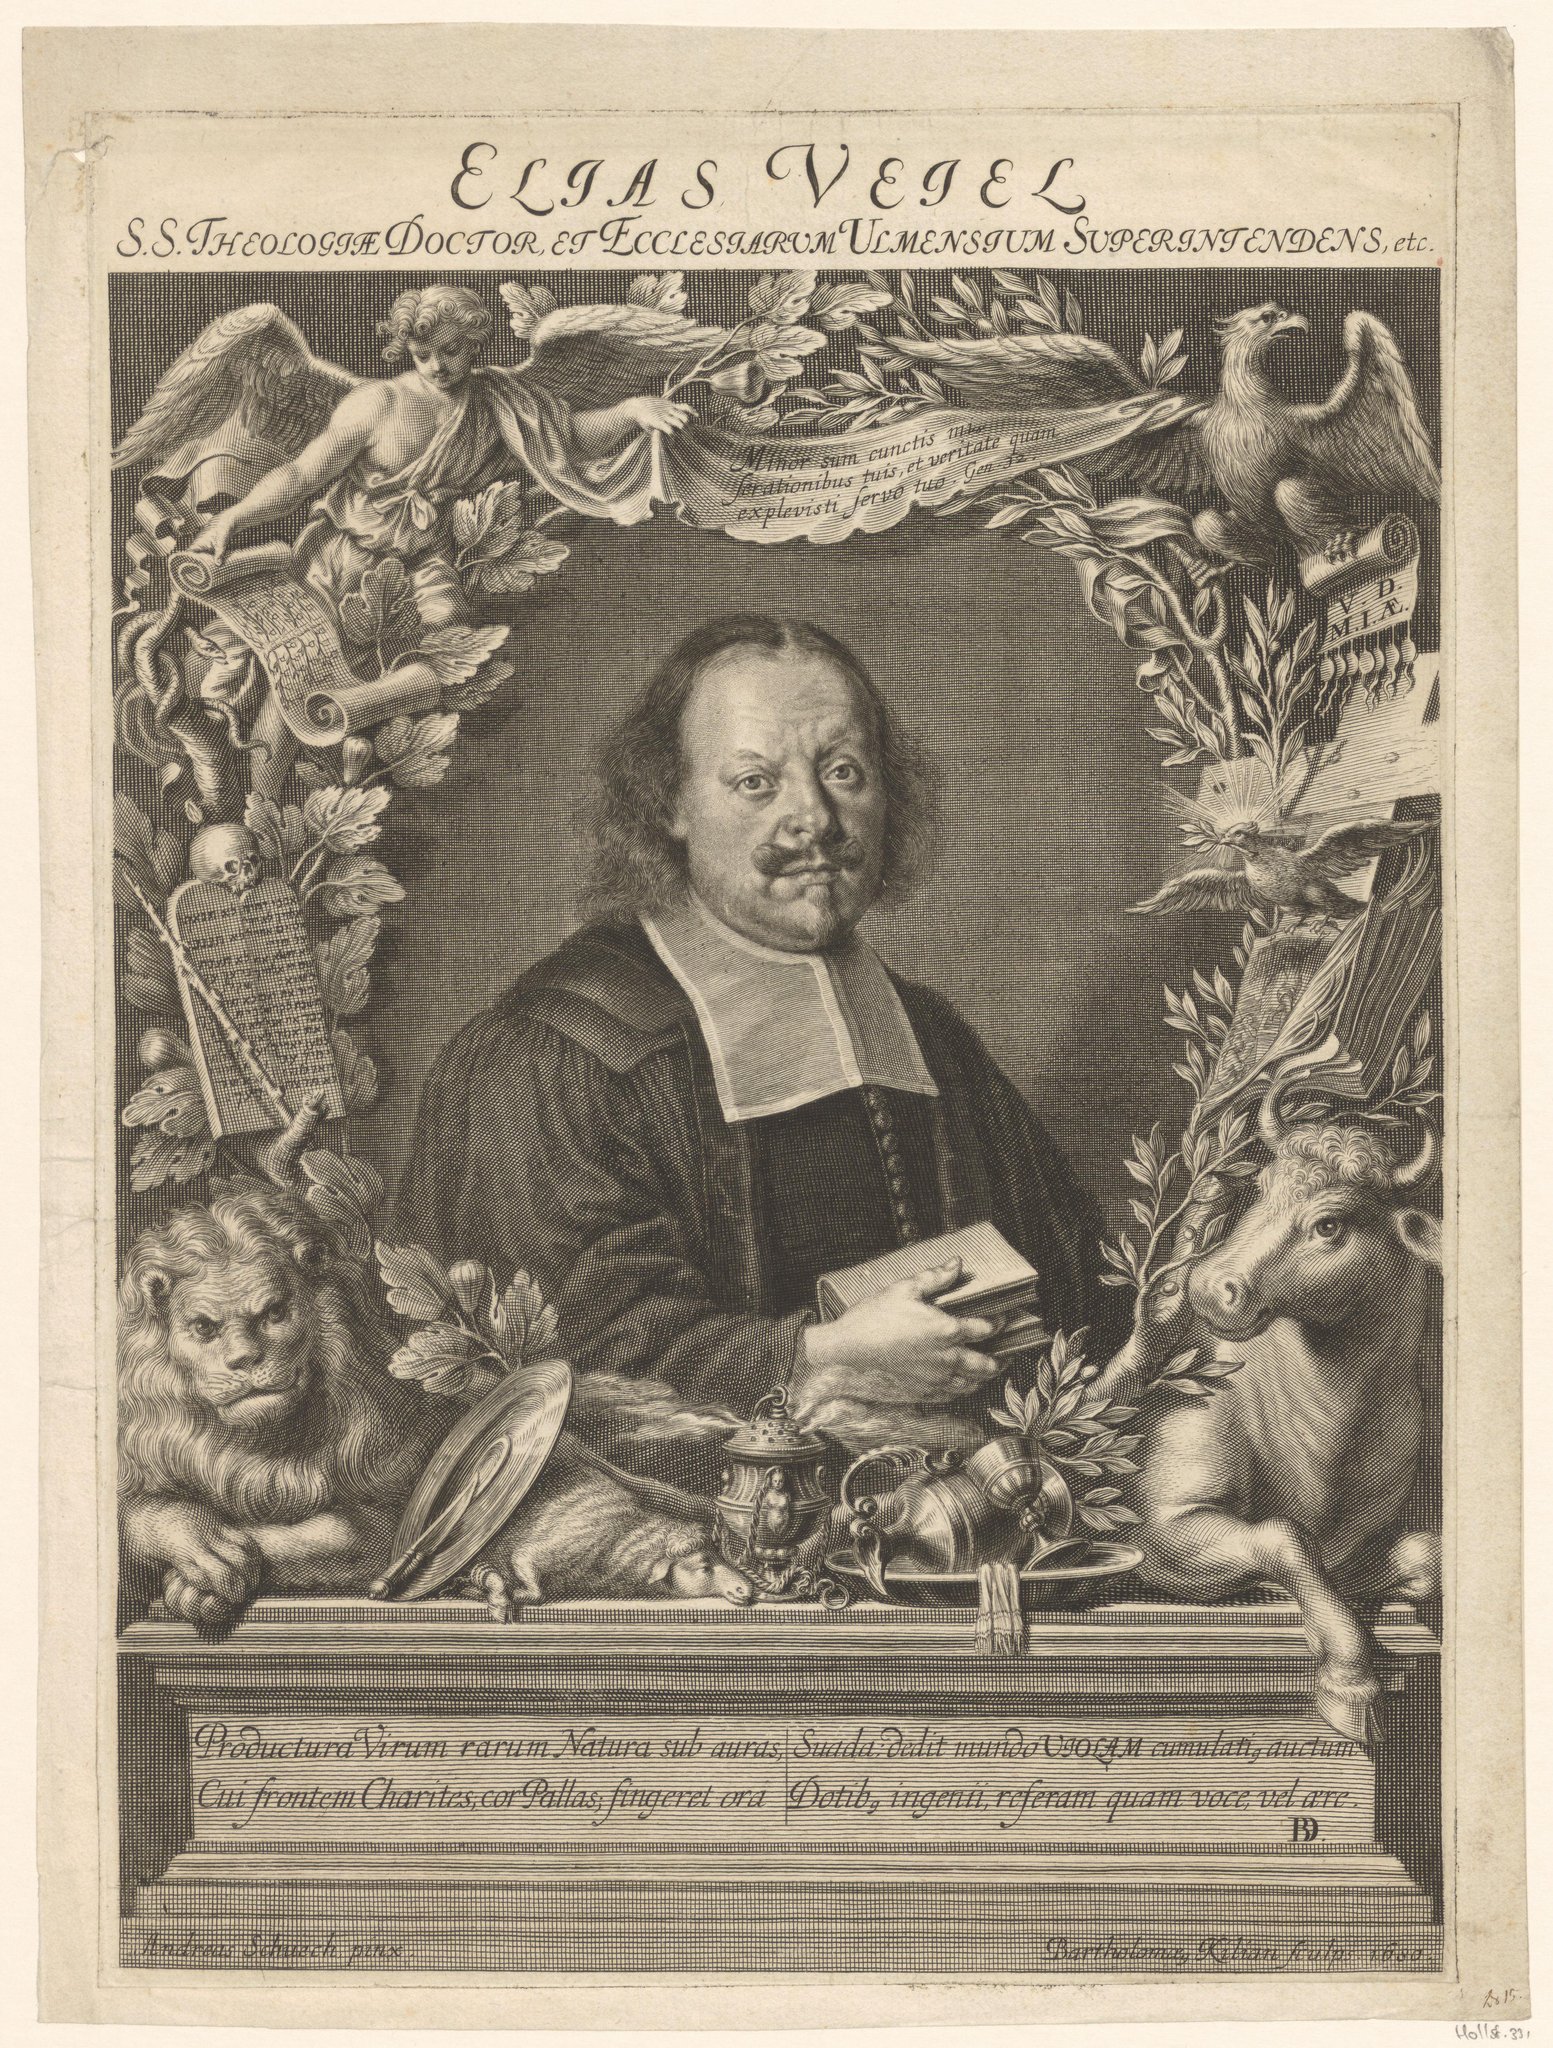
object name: print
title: Portret van Elias Vegel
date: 1680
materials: paper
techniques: engraving, etching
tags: theologian, historical persons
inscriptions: collector's mark: Lugt 2228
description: Tekst in het Latijn op de sokkel en in de marge bovenin. Christelijke iconografie in de omlijsting, waaronder de vier evangelisten.